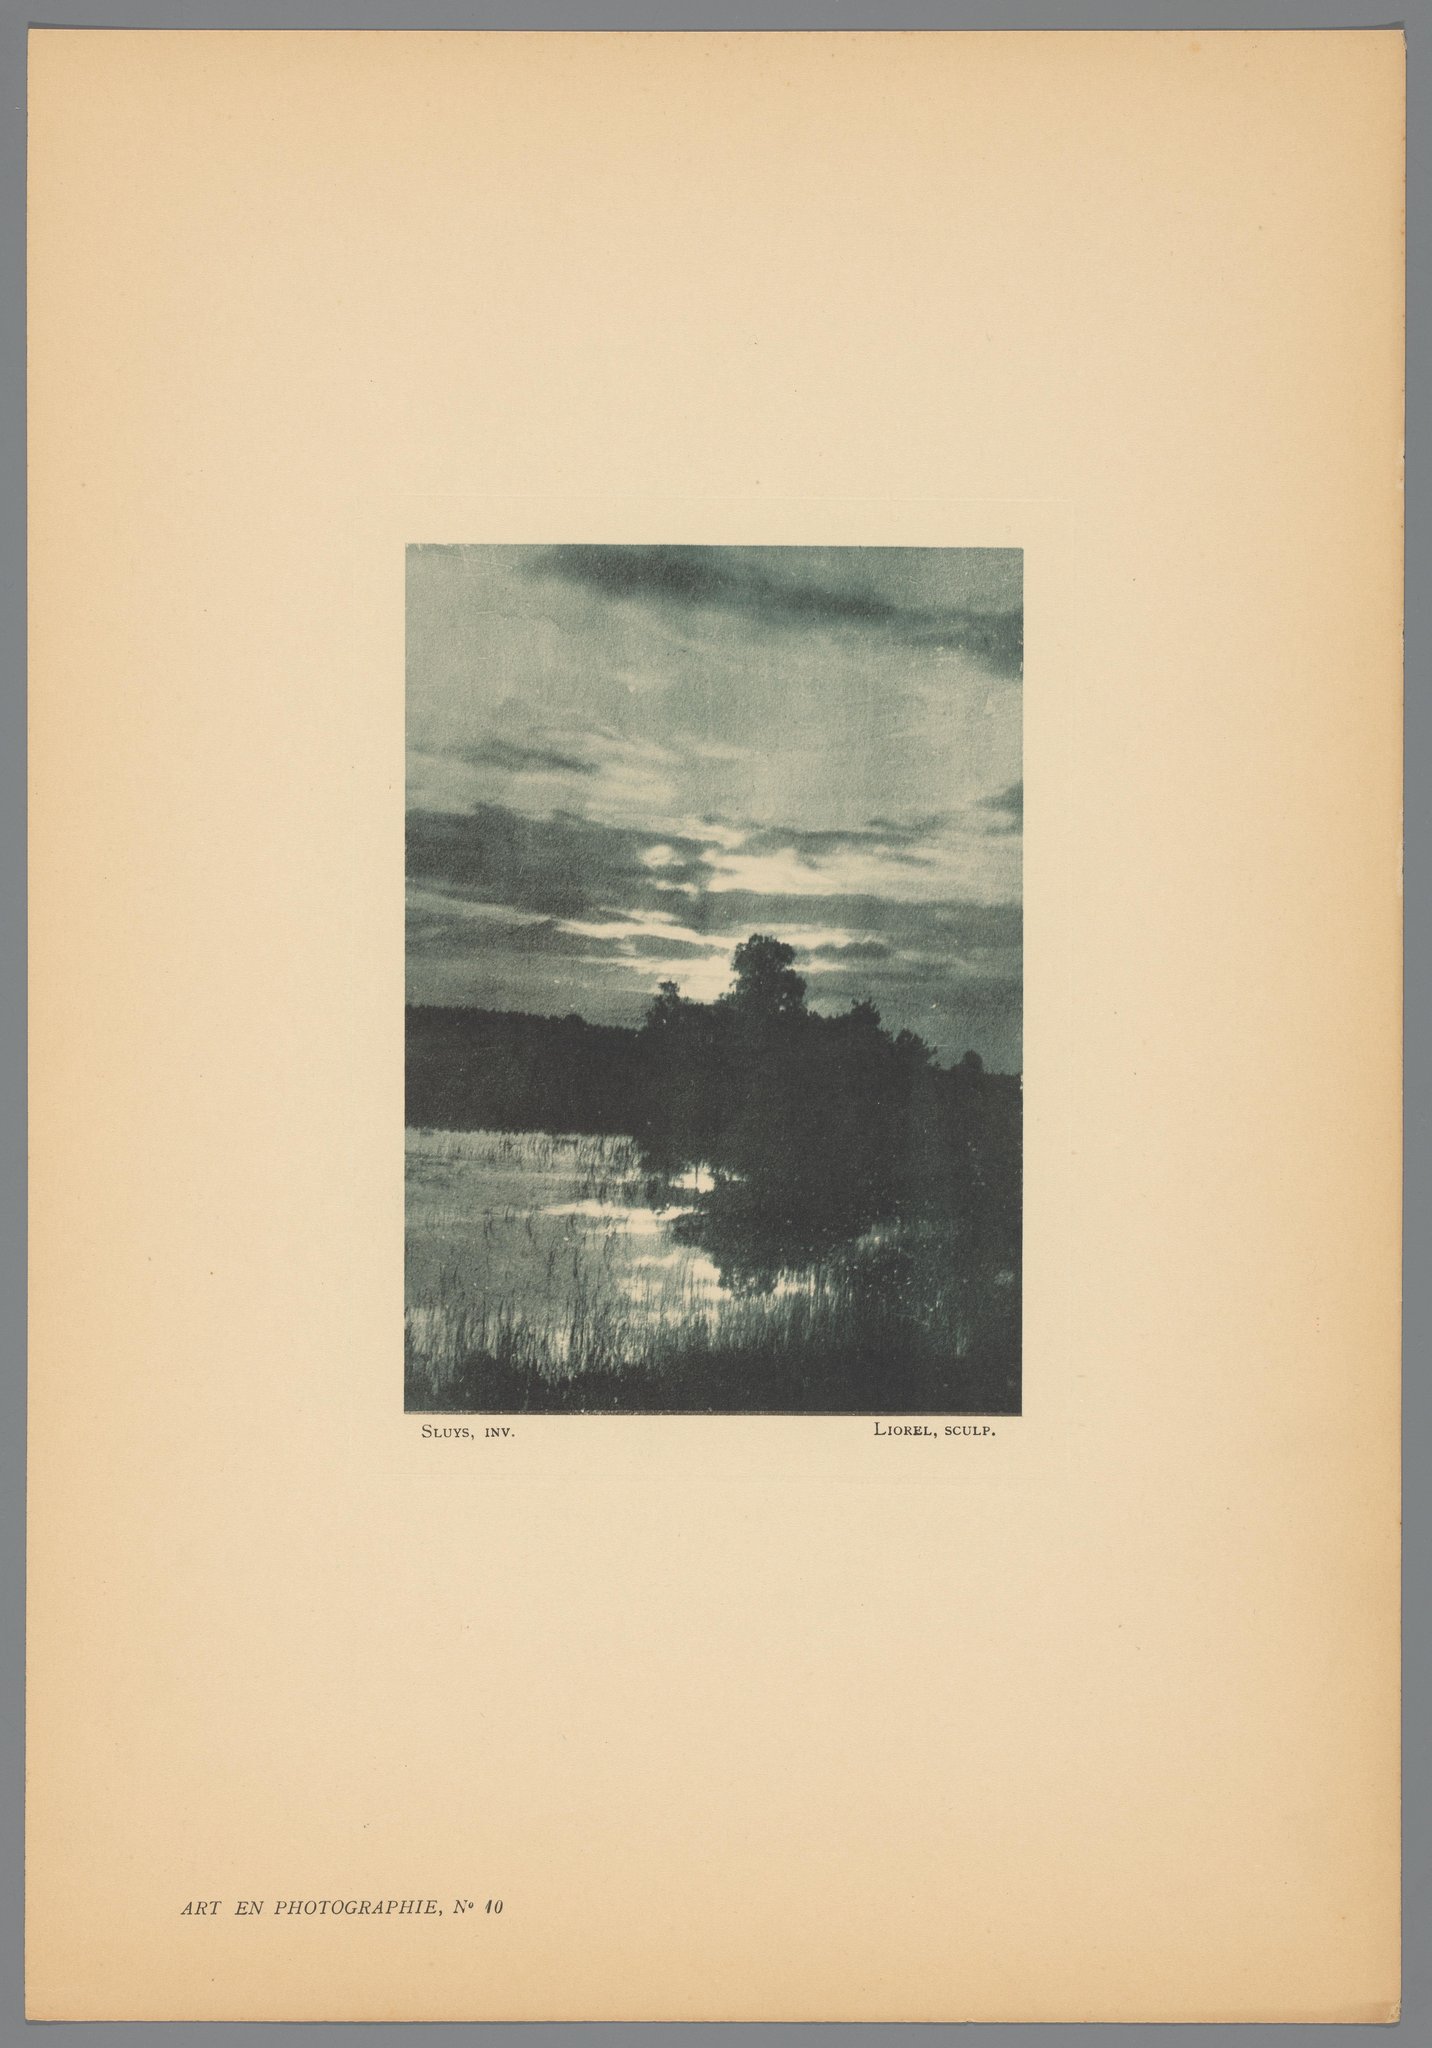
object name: photomechanical print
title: Landschap met waterpartij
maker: paul sluys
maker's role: fotograaf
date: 1896-1901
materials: paper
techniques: photograph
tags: water course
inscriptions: inscription: ‘ART EN PHOTOGRAPHIE, No 10’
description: Deze prent maakt deel uit van een omslag met 54 prenten op 52 bladen.